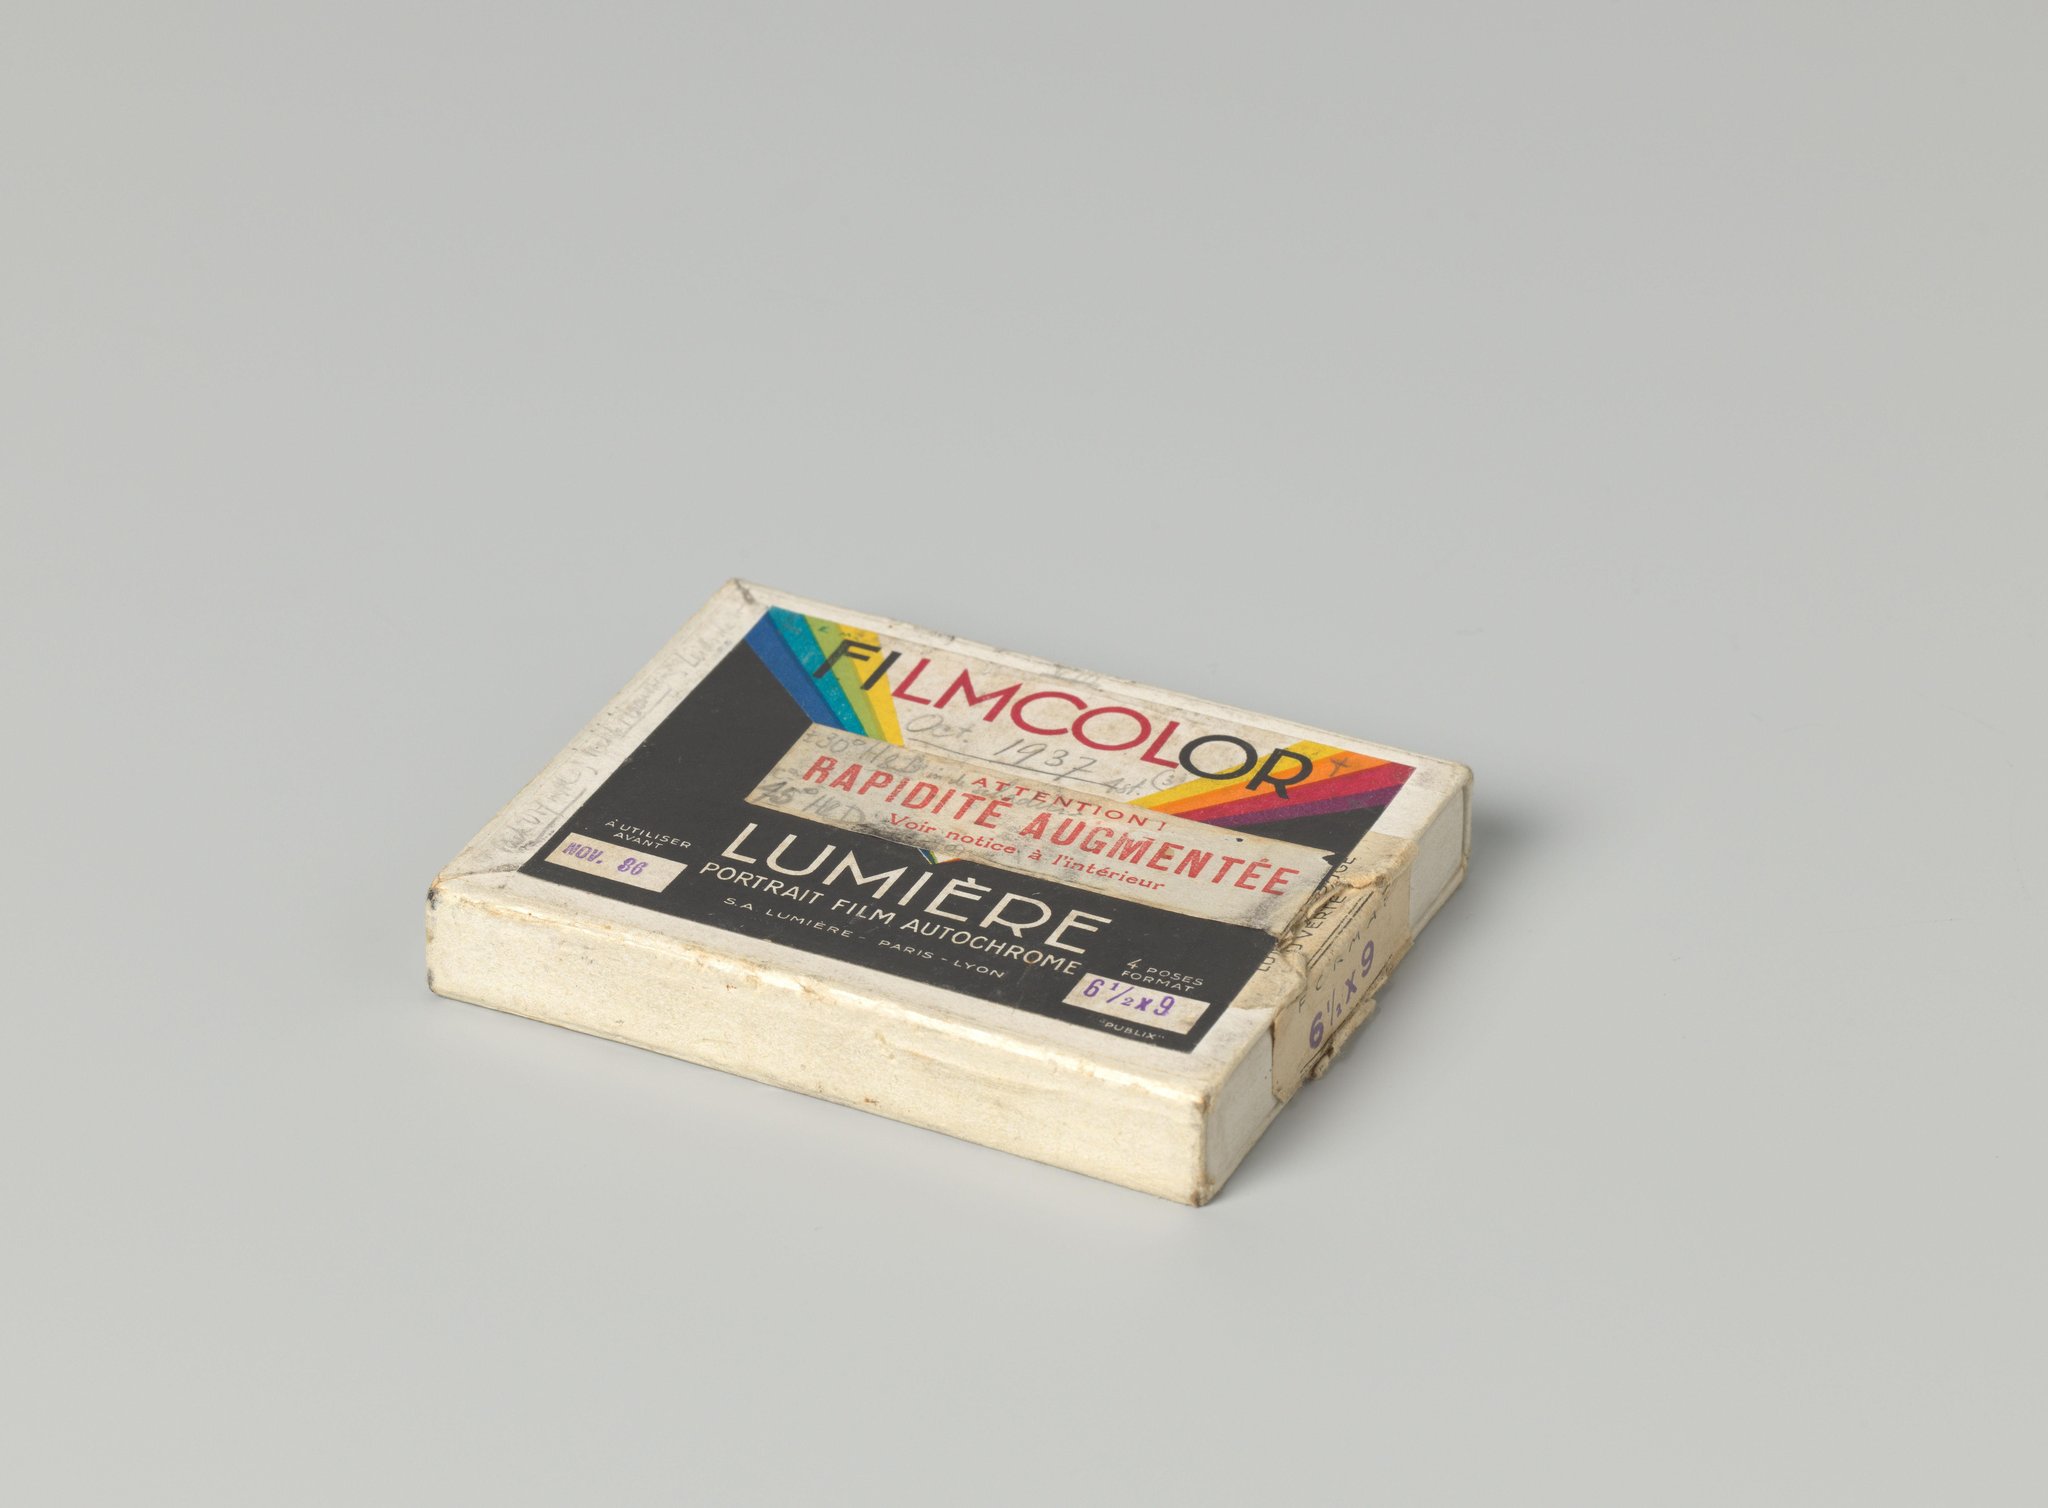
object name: box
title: Doos voor autochromes van Lumière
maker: lumière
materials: cardboard, paper, tape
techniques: printing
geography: france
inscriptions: inscription: ‘Oct. 1937/ 4 st. (3)’, date: ‘À UTILISER/ AVANT/ NOV. 36’